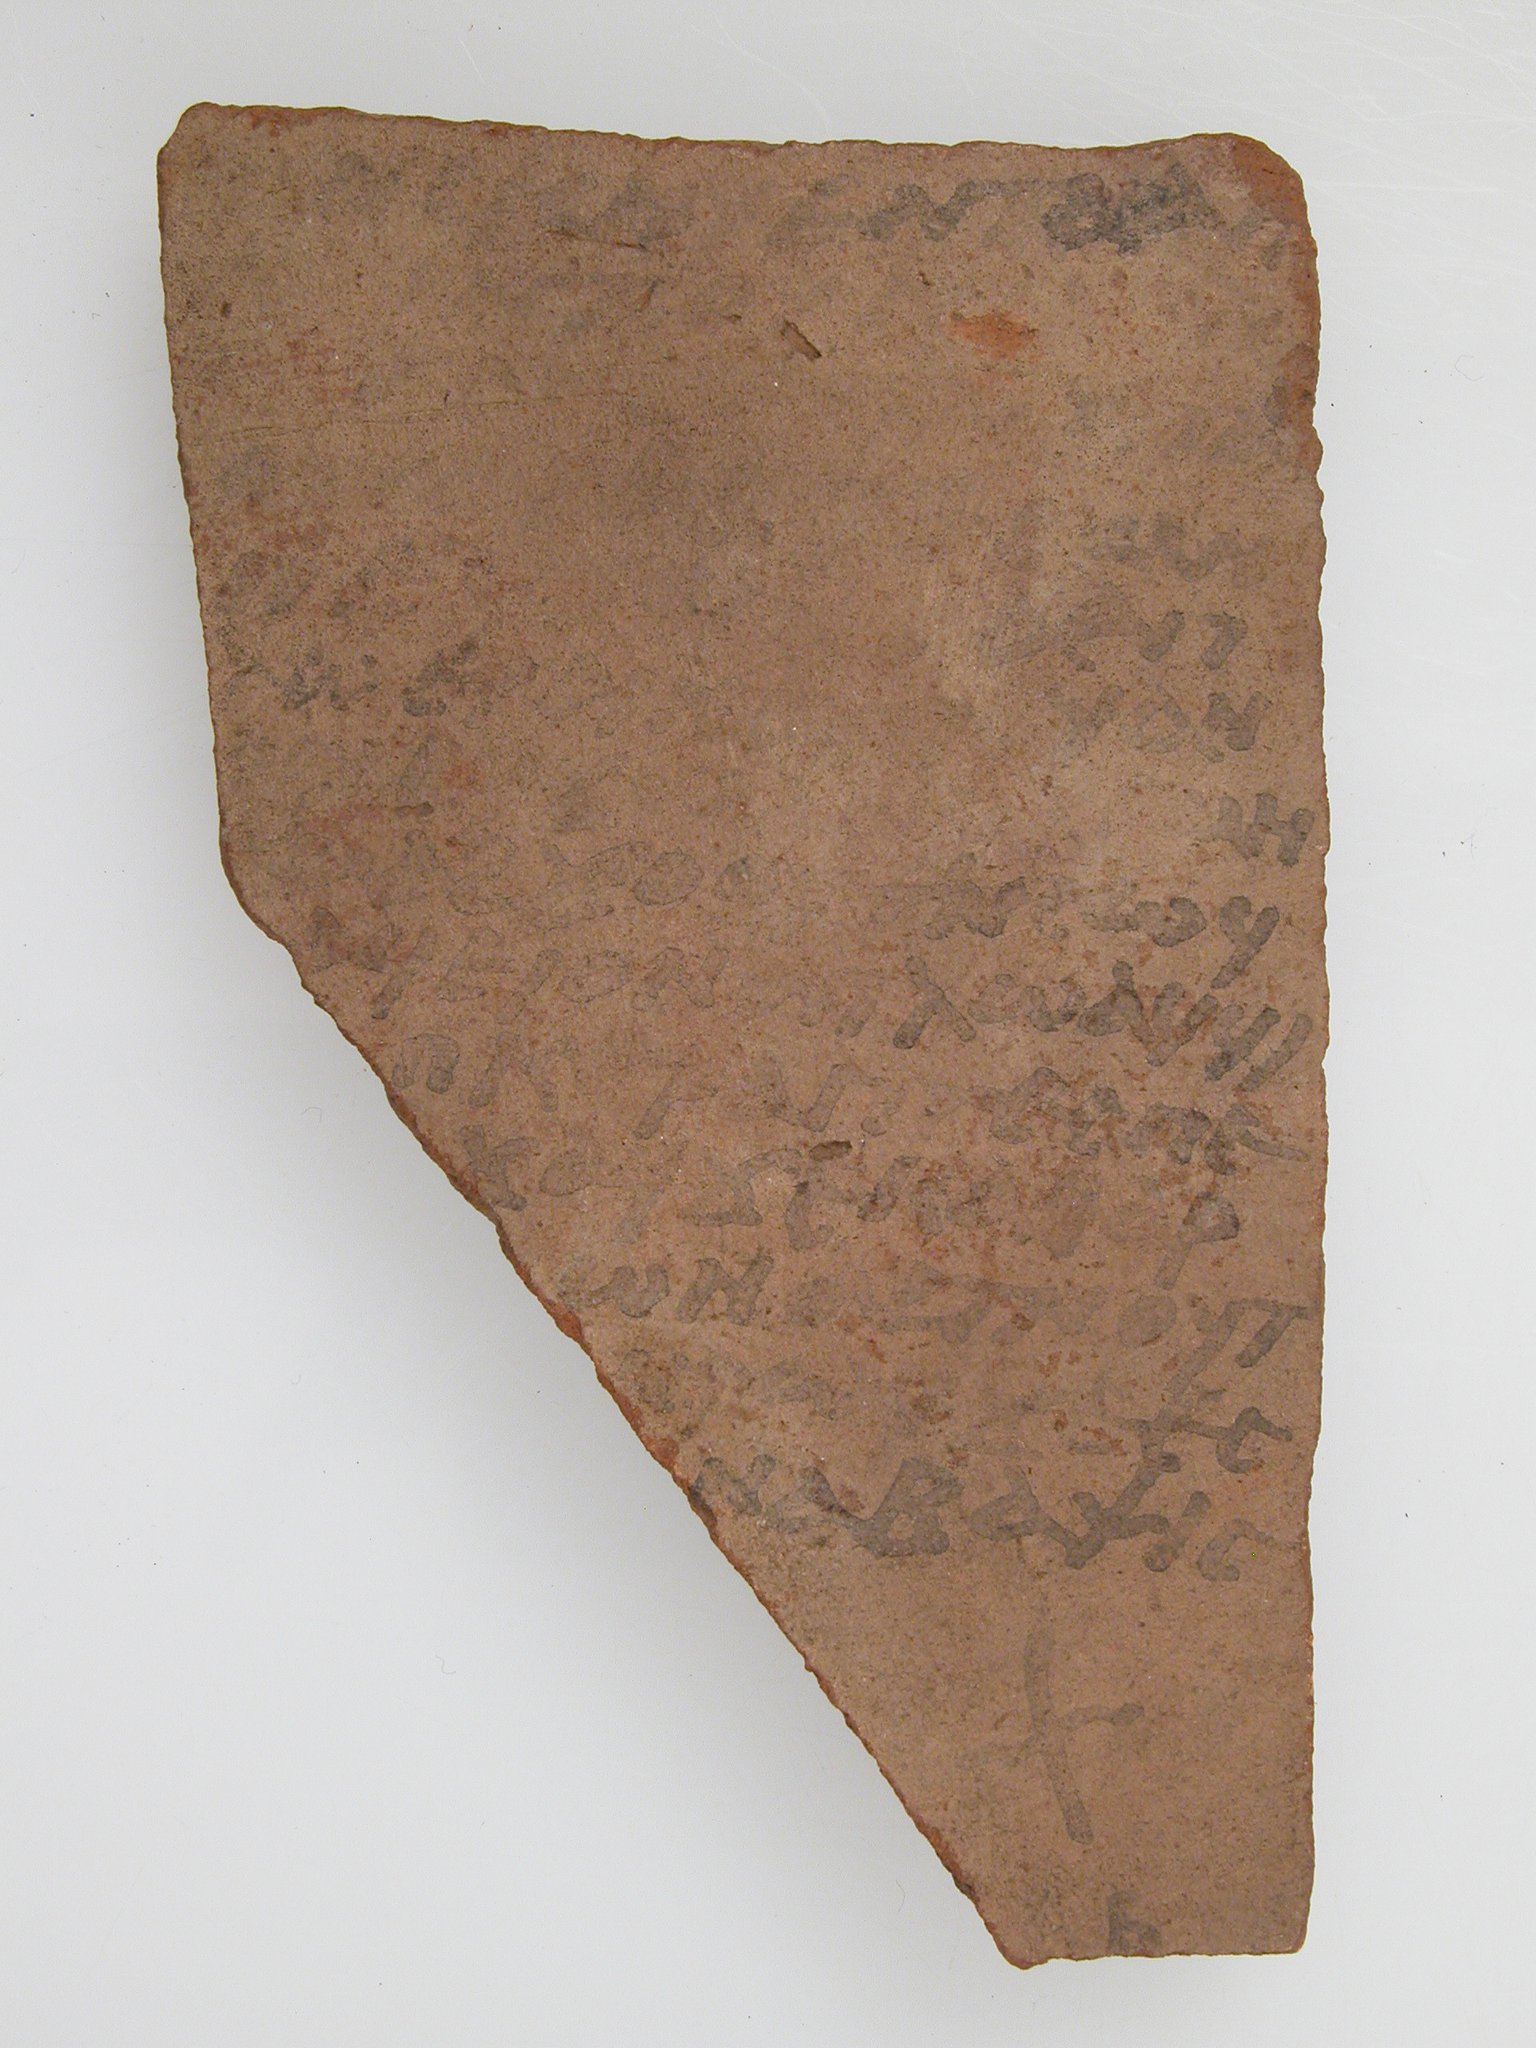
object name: ostrakon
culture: coptic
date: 601-700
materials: ink, pottery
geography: egypt